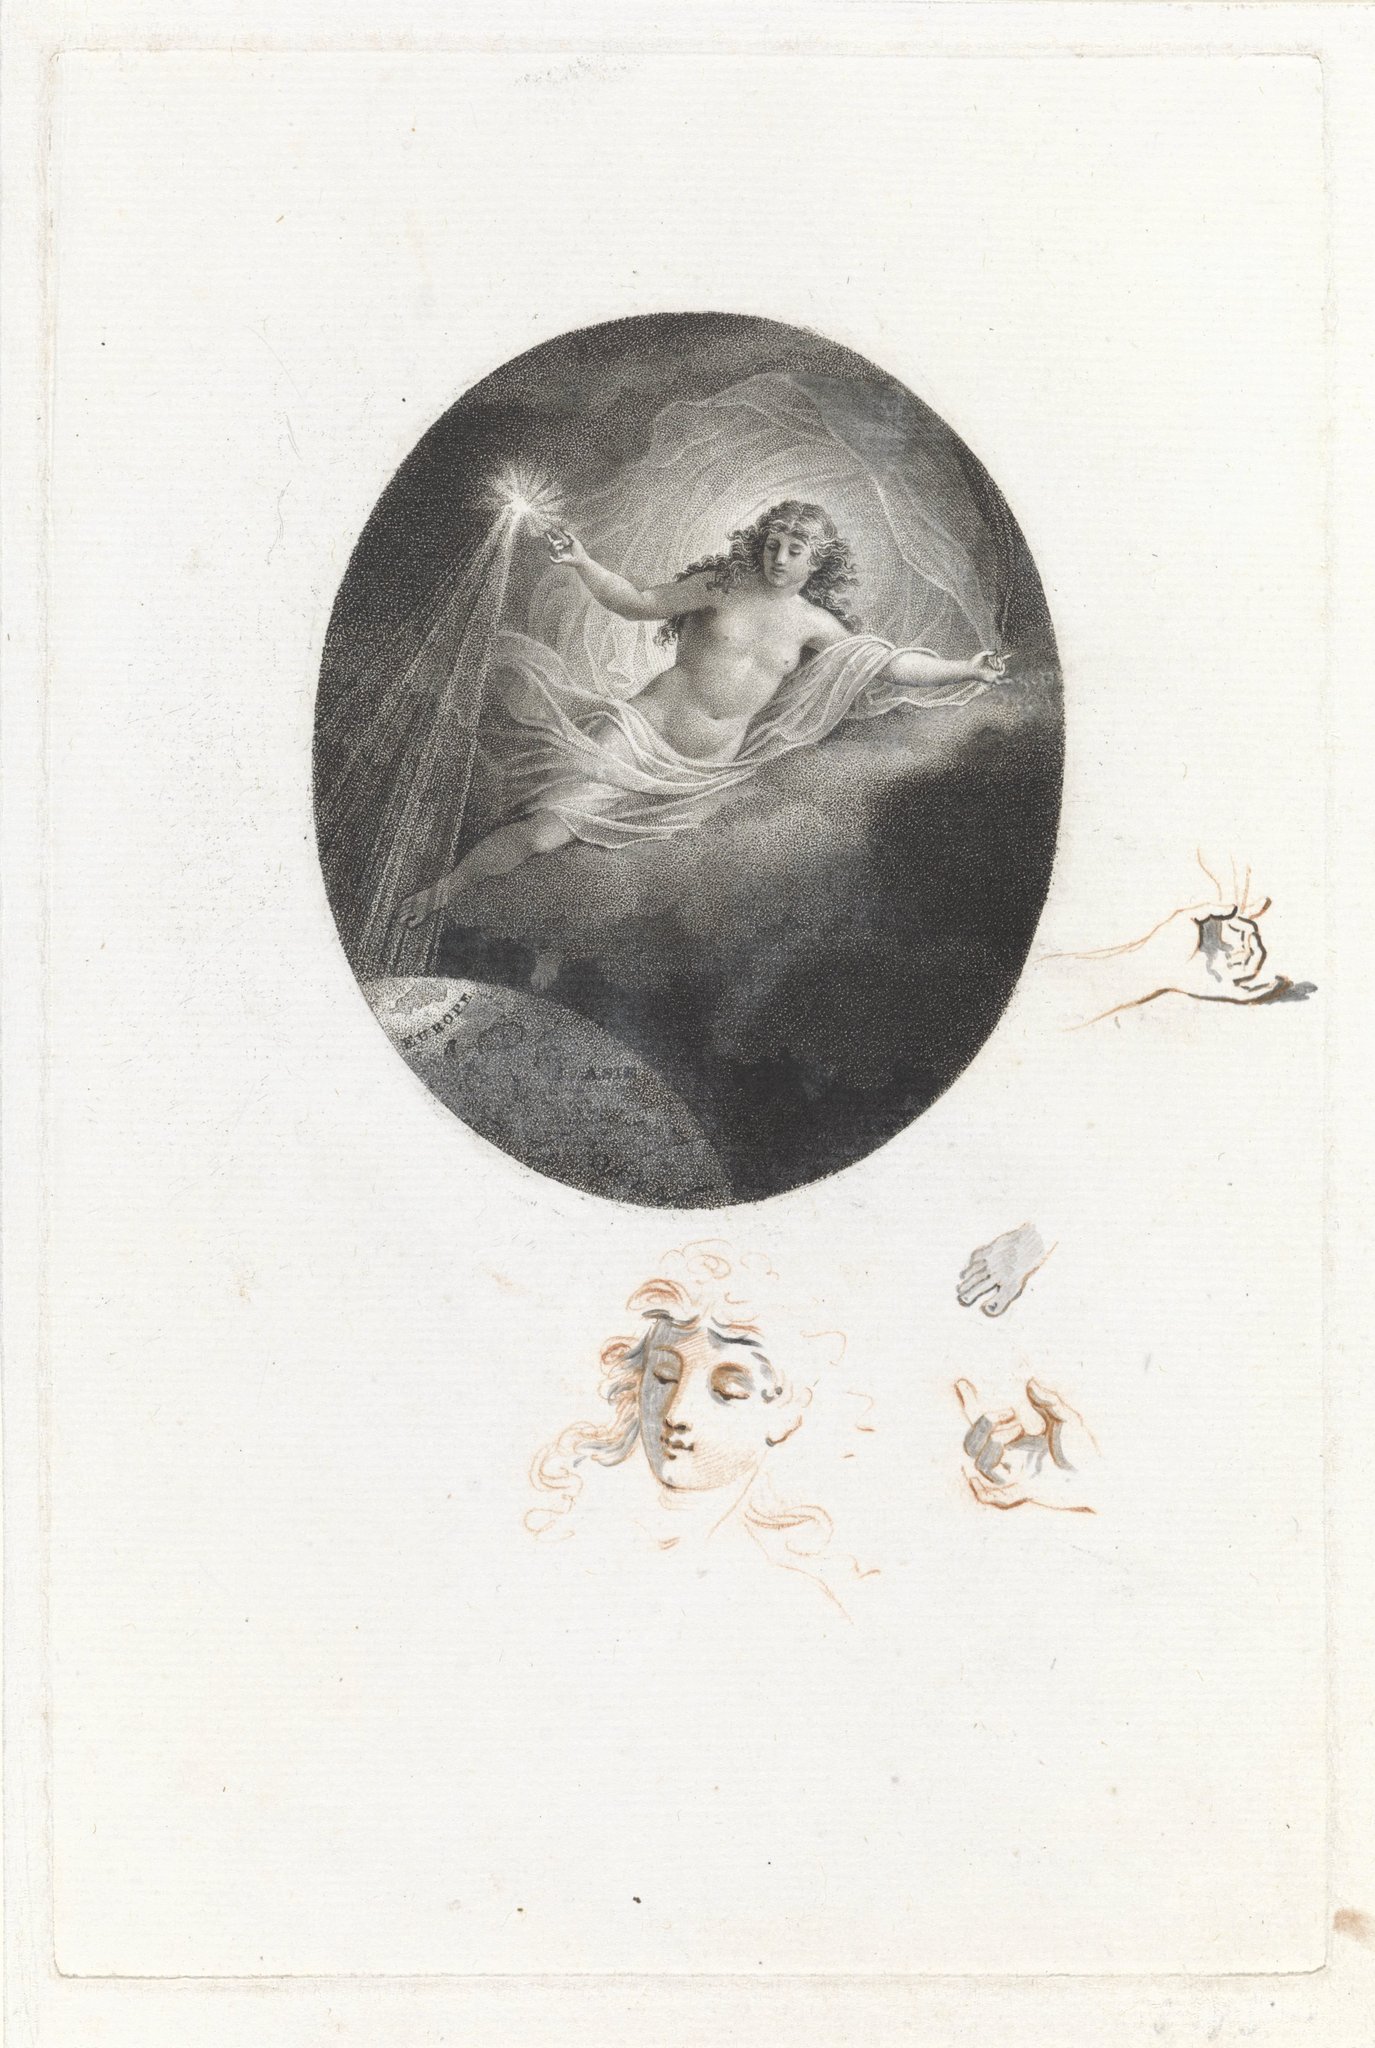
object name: print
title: Allegorie op de Verlichting, 1795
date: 1795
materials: chalk, paint, paper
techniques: brush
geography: netherlands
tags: light shining out of the heavens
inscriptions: collector's mark: Lugt 2228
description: Allegorie op de Verlichting, 1795. De vrouwelijke personificatie van de Verlichting zweeft boven de wereld en laat haar licht op Europa schijnen. Op het blad enkele getekende studies van details van handen, voet en hoofd.